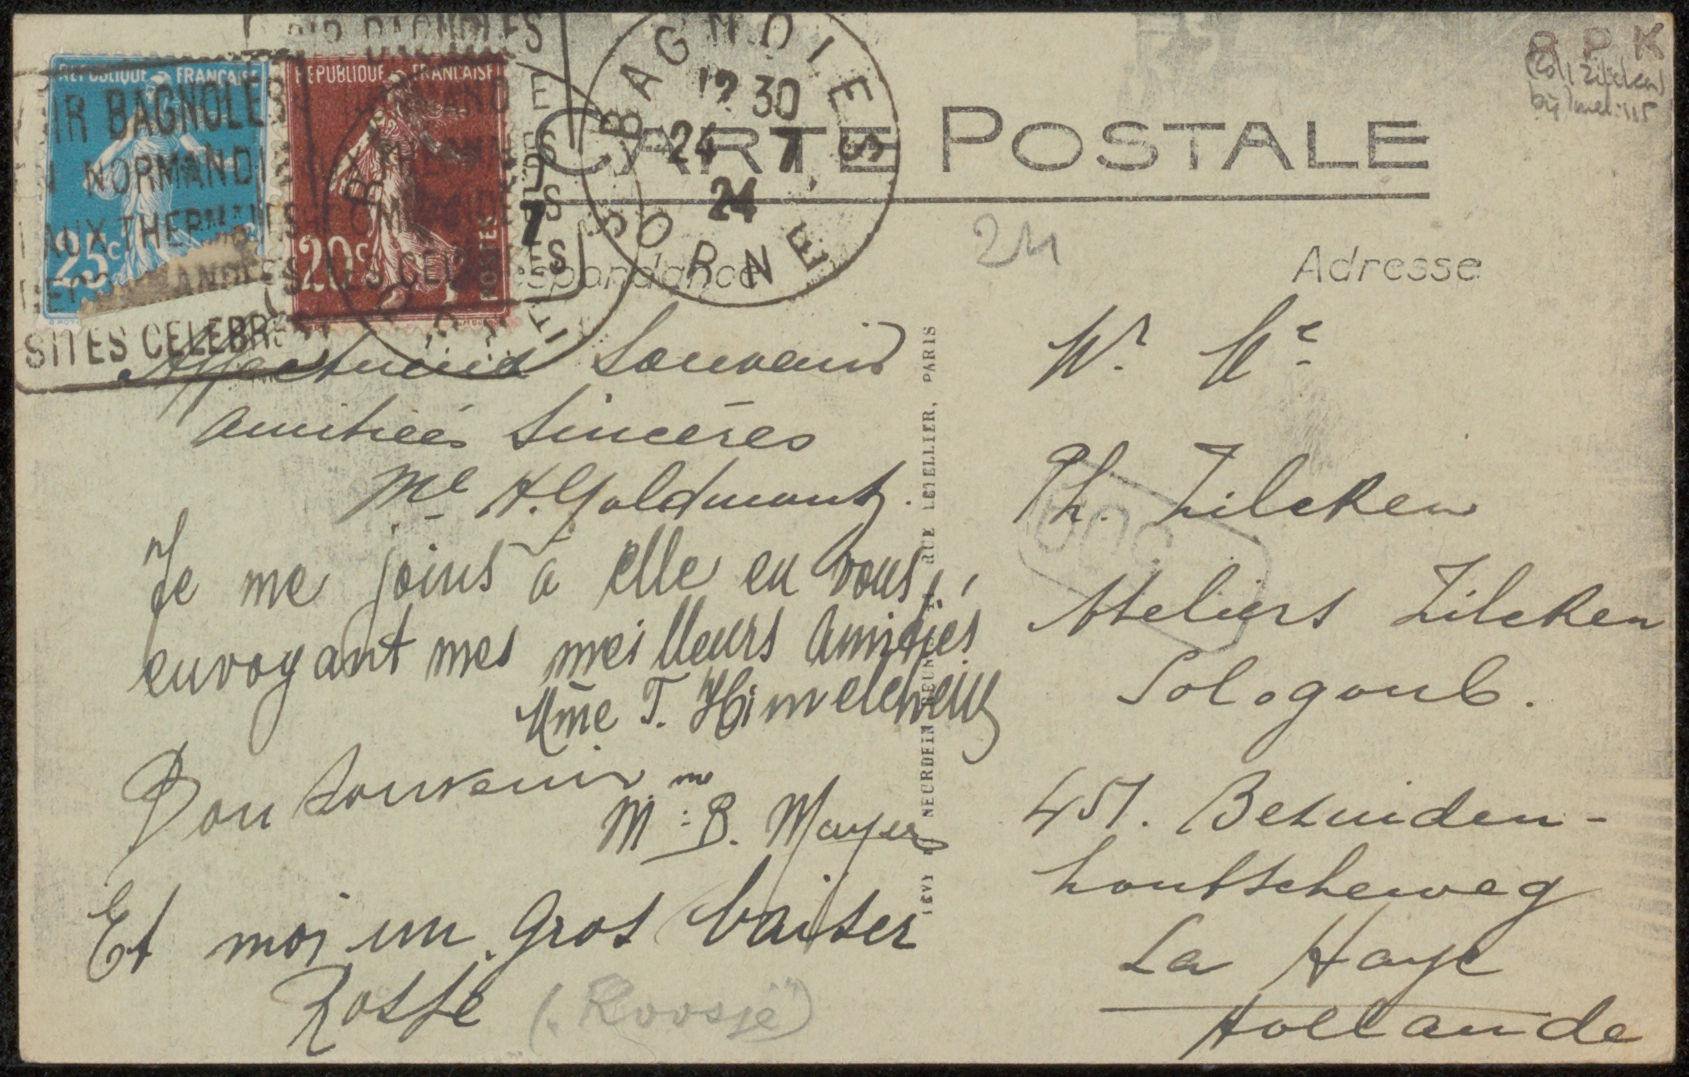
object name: ansichtkaart, prentbriefkaart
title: Prentbriefkaart aan Philip Zilcken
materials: cardboard, ink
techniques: photograph, pen, writing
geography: paris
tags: the hague, draughtsman, philip zilcken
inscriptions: collector's mark: ‘RPK’